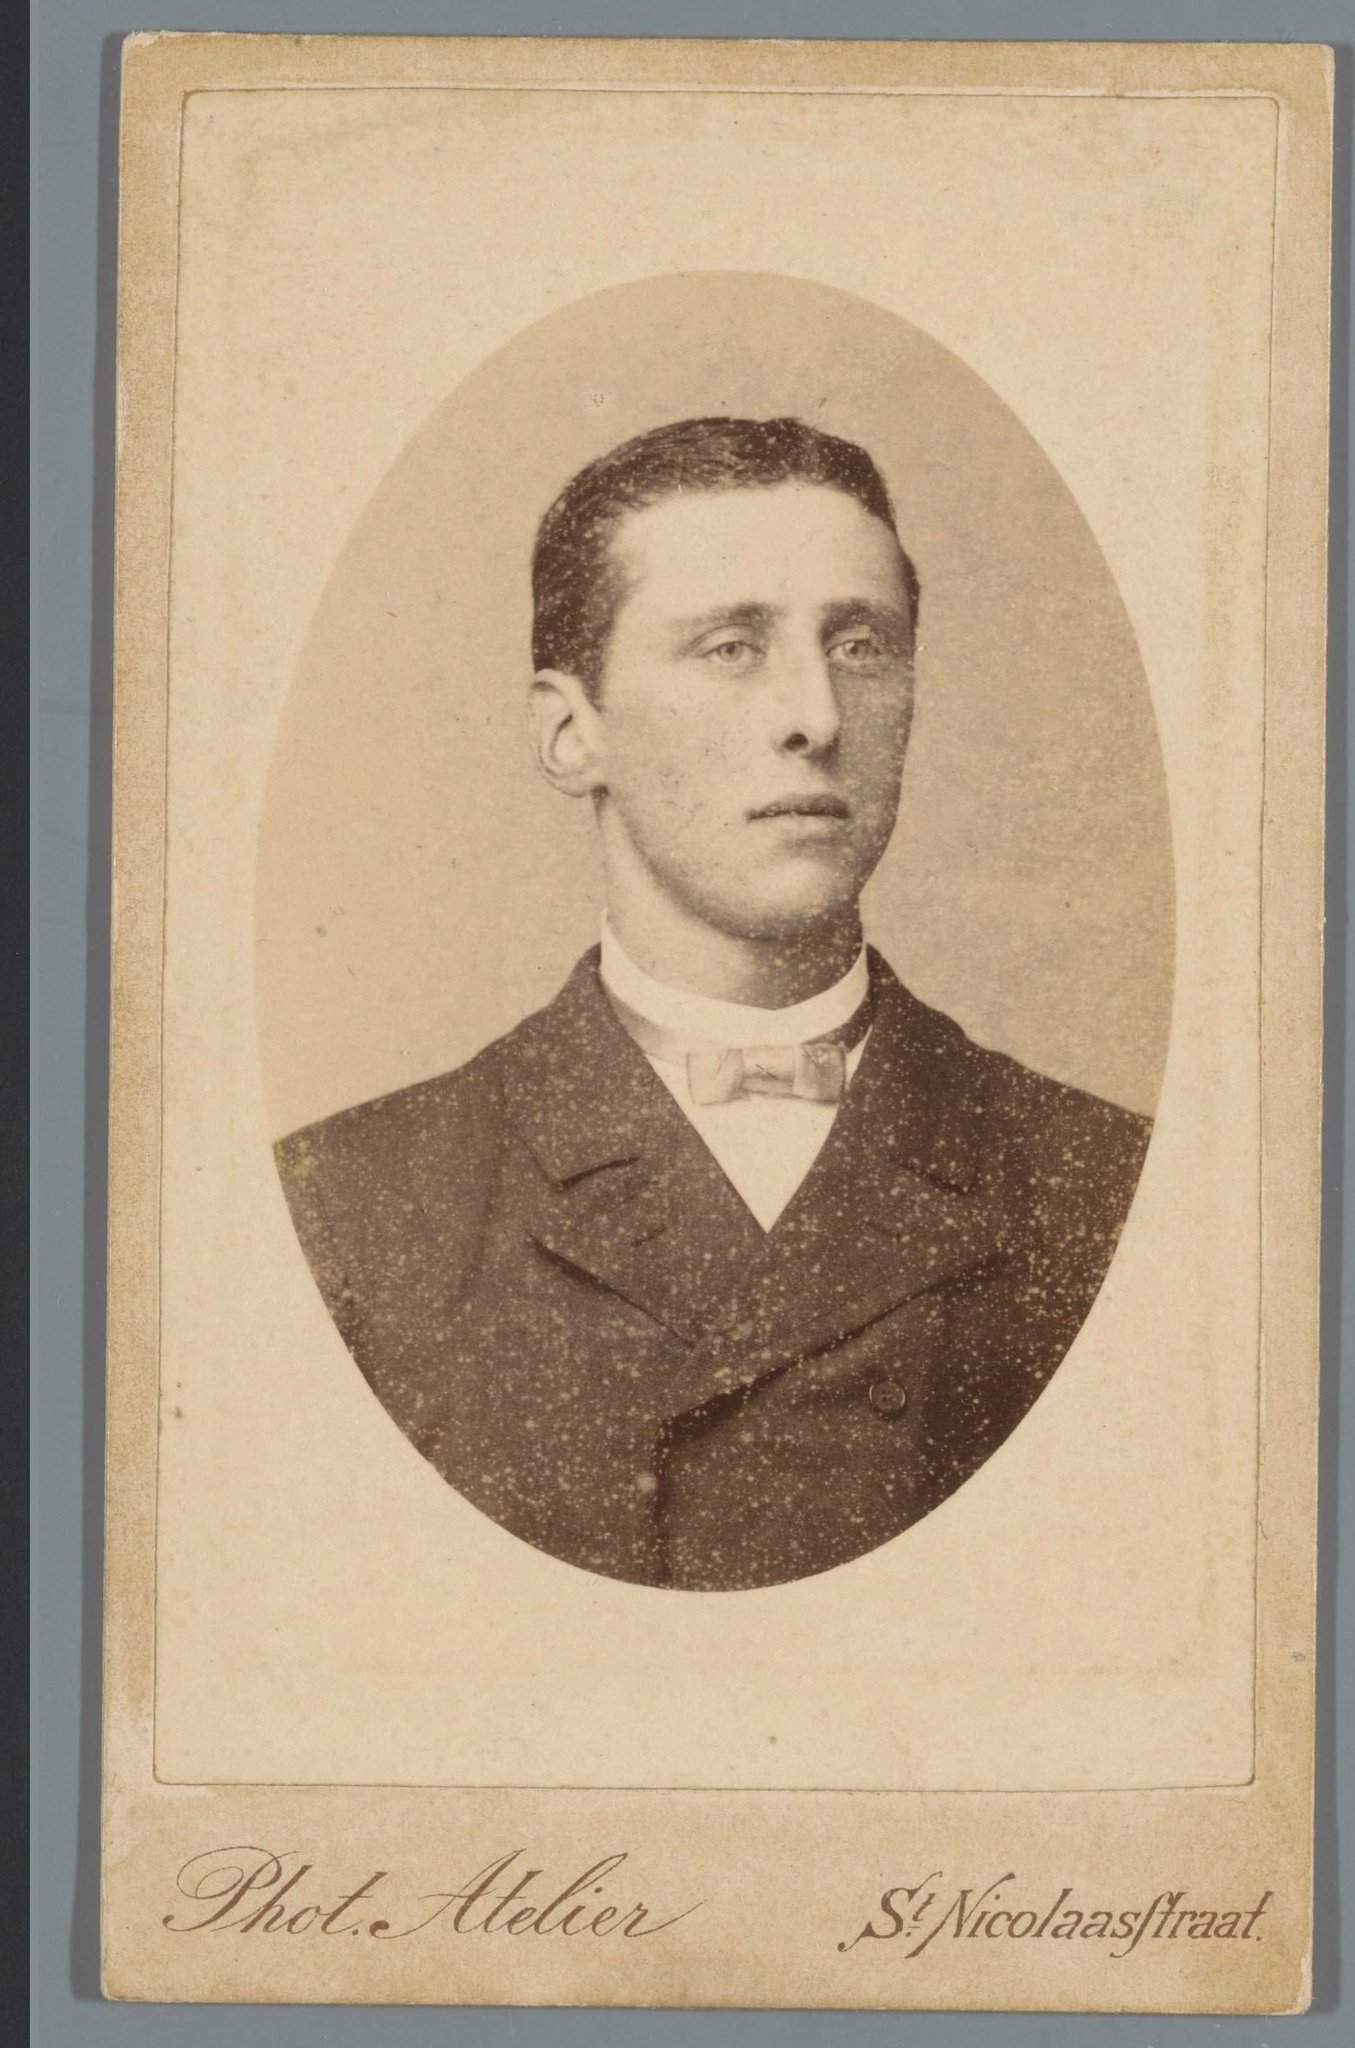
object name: carte de visite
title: Portret van een onbekende man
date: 1880-1900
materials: cardboard, paper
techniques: albumen print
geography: enkhuizen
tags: adult man, historical persons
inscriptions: inscription: ‘Photographisch/ Atelier/ St. Nicolaasstraat/ bij het Verlaat/ ENKHUIZEN./ Muster geschützt W.W. 24’